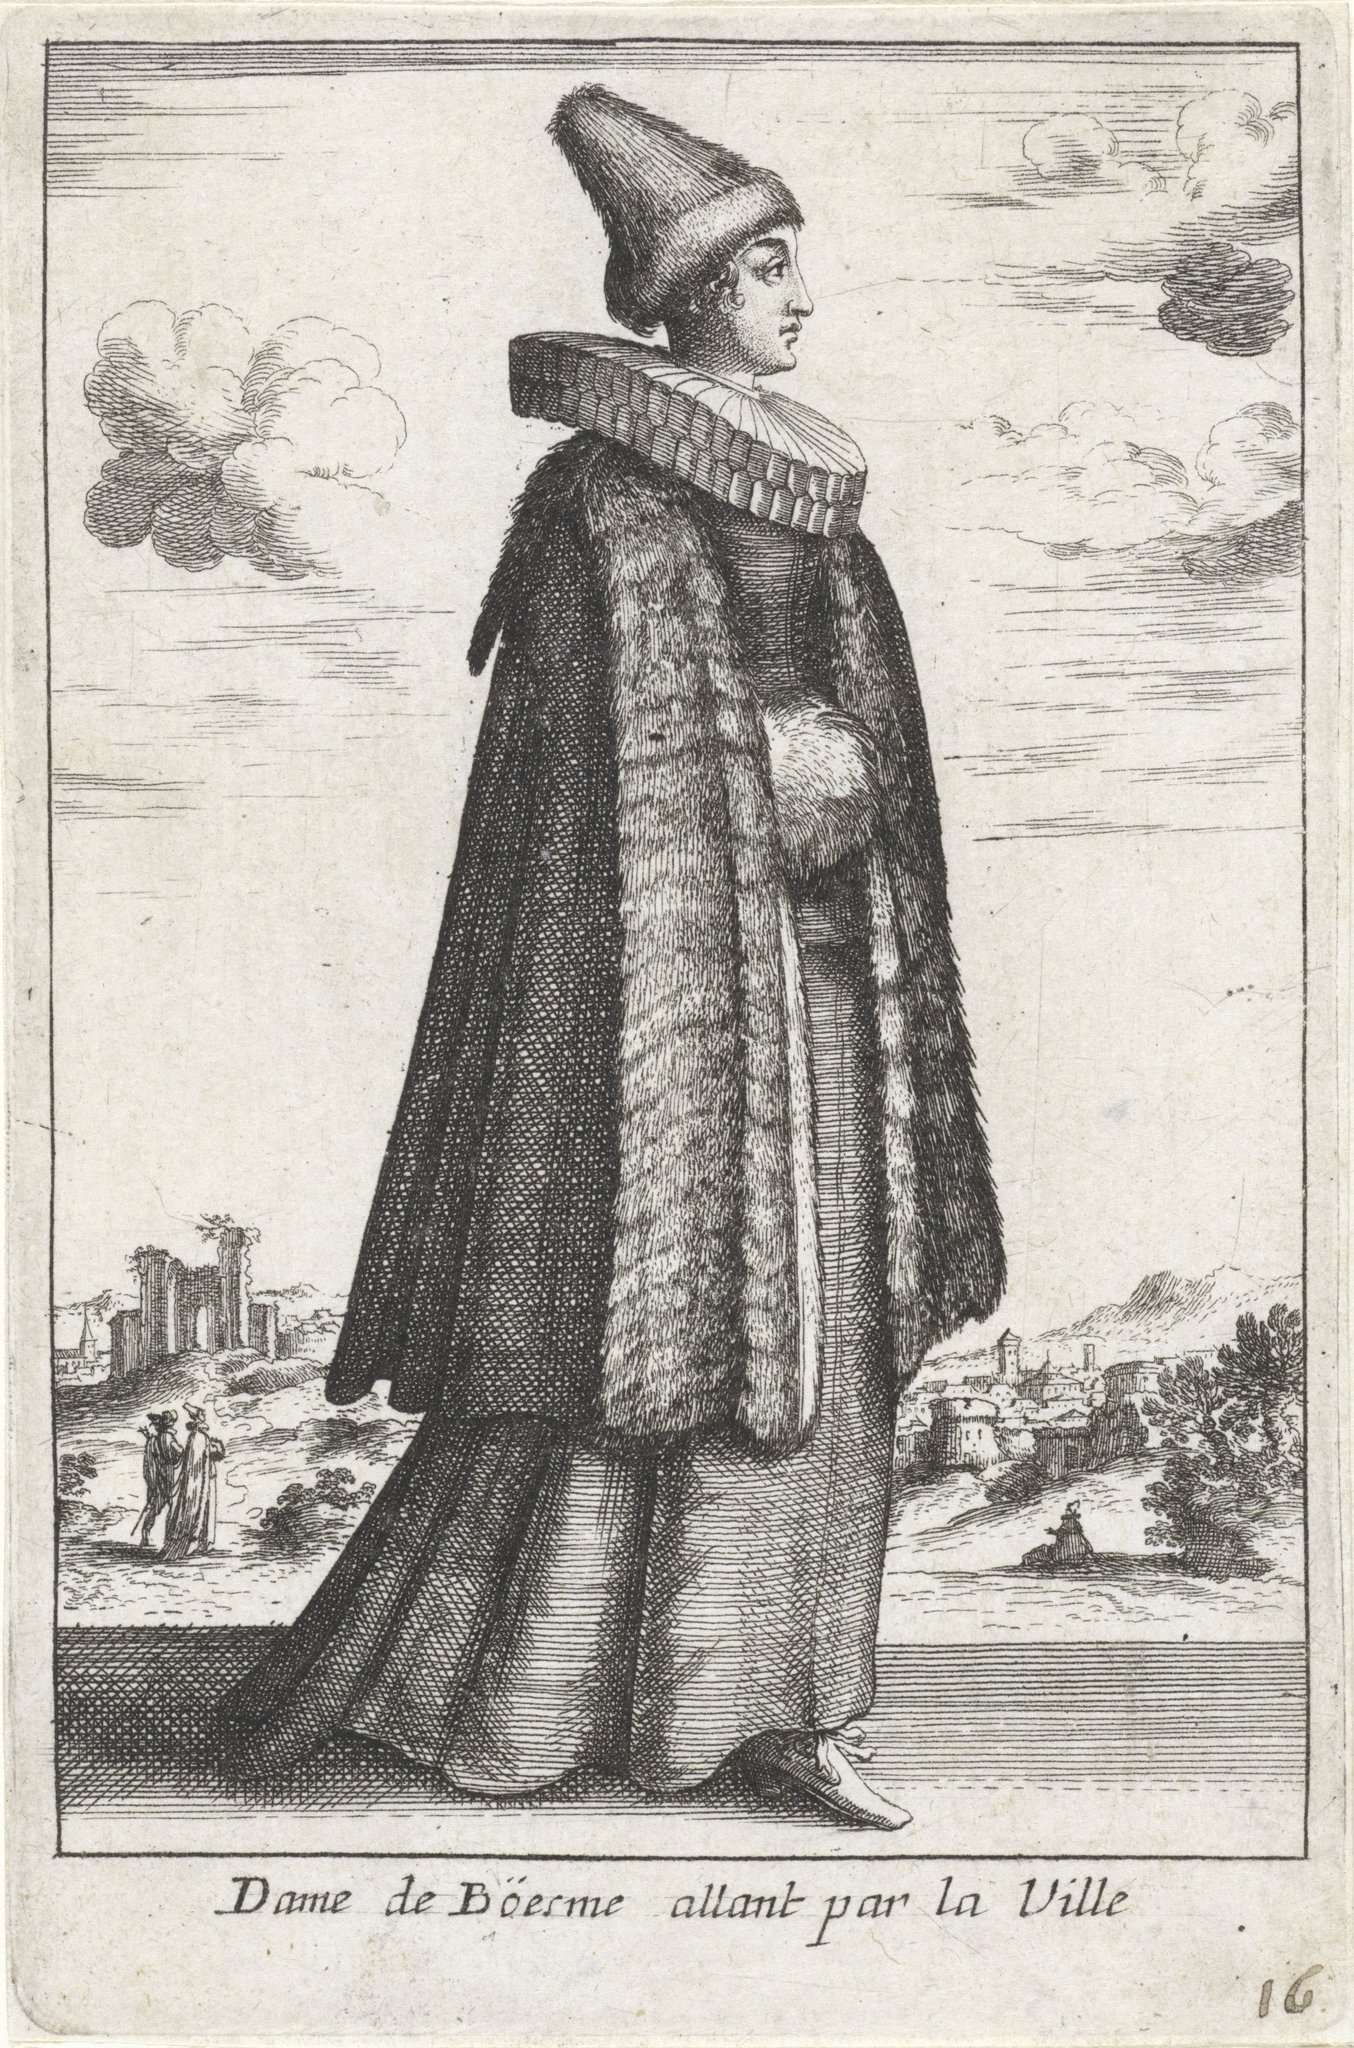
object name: costume print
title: Vrouwen in klederdracht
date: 1662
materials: paper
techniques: etching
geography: paris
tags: bohemen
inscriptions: number: ‘16’, collector's mark: Lugt 240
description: Kopie naar prent die deel uitmaakt van de 50-delige serie met Europese klederdrachten, getiteld "Aula Veneris".. De prent maakt deel uit van de 28-delige serie (excl. titelprent) met voorstellingen van vrouwen in verschillende klederdrachten, getiteld "Livre curieux contenant la naifue representations des habits des femmes des diverses parties du Monde (...), 1662".